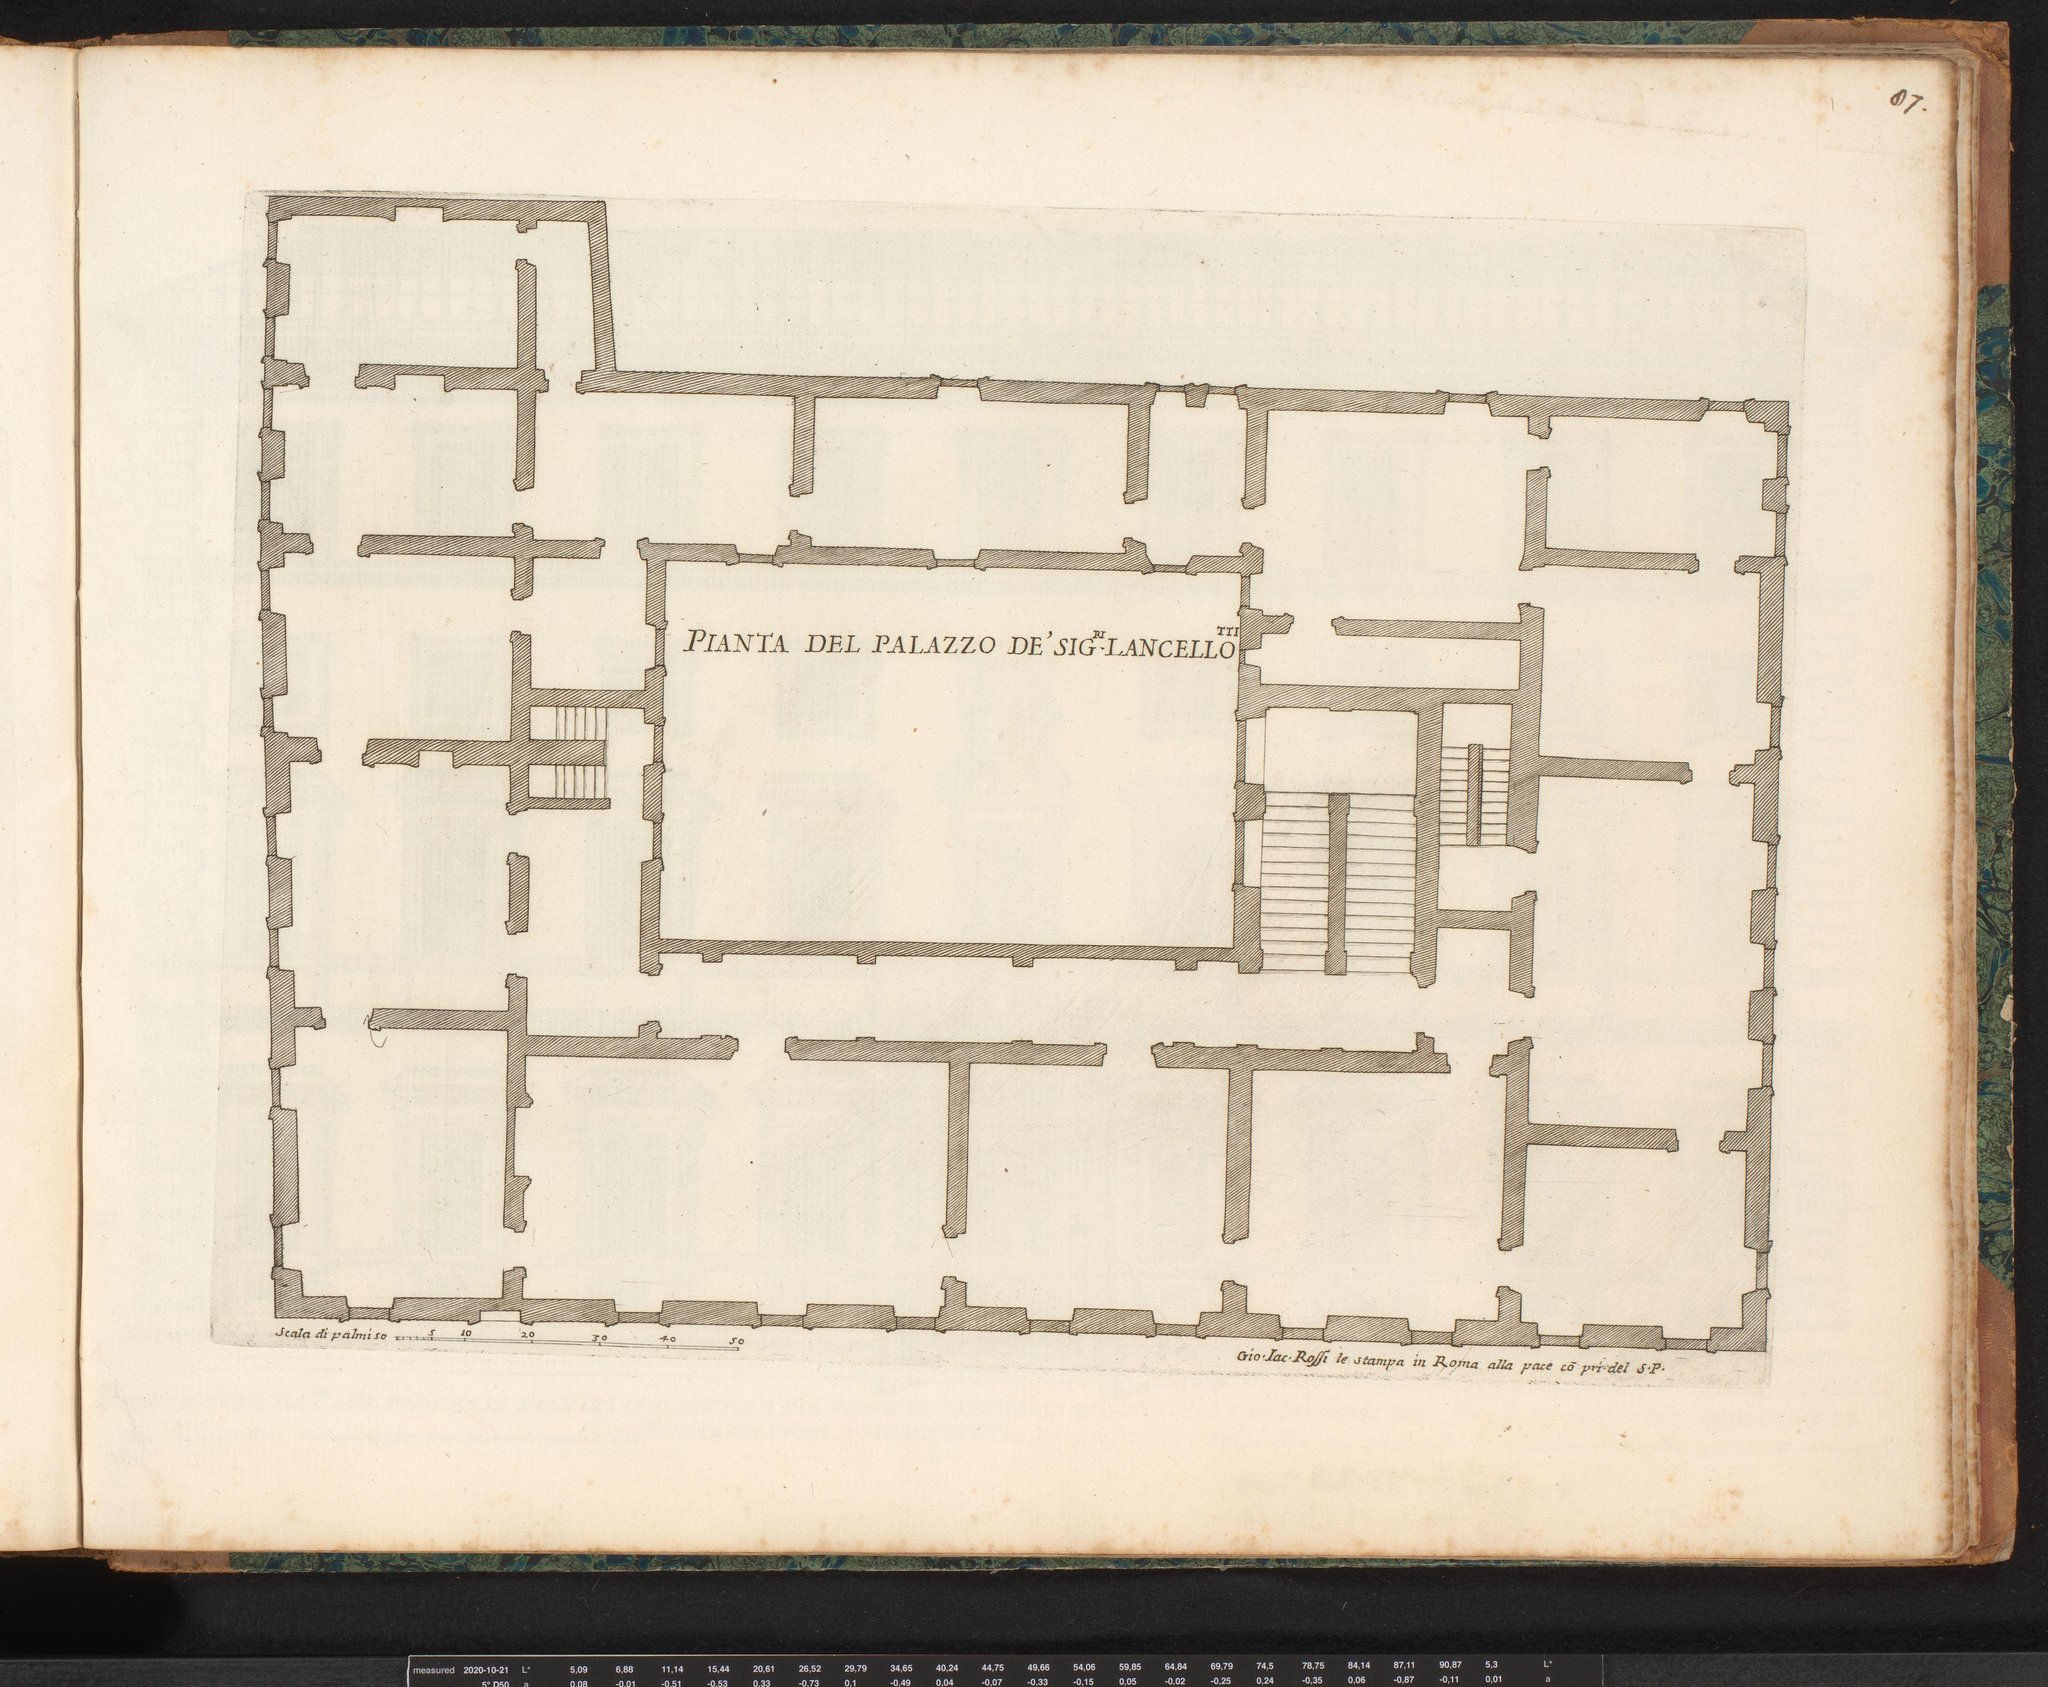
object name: album leaf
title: Palazzi di Roma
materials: paper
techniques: etching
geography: rome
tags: palace, plan ~ architecture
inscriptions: number: ‘87’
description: Deze prent maakt deel uit van de reeks getiteld: Palazzi di Roma. Deze reeks bestaat uit twee boeken. Boek één getiteld: Palazzi di Roma dei più celebri architetti..., bestaat uit 44 prenten die worden toegeschreven aan Giovanni Battista Falda (naam staat enkel op prent 27) en uitgegeven door Giovanni Giacomo de'Rossi. Deze 44 prenten zijn bekend in twee staten (met en zonder nummer). Boek twee getiteld: Nuovi disegni dell'architetture... libro secondo, bevat 66 prenten door Giovanni Battista Falda en Simone Felice. Deze 66 prenten zijn bekend in twee staten (met en zonder nummer).